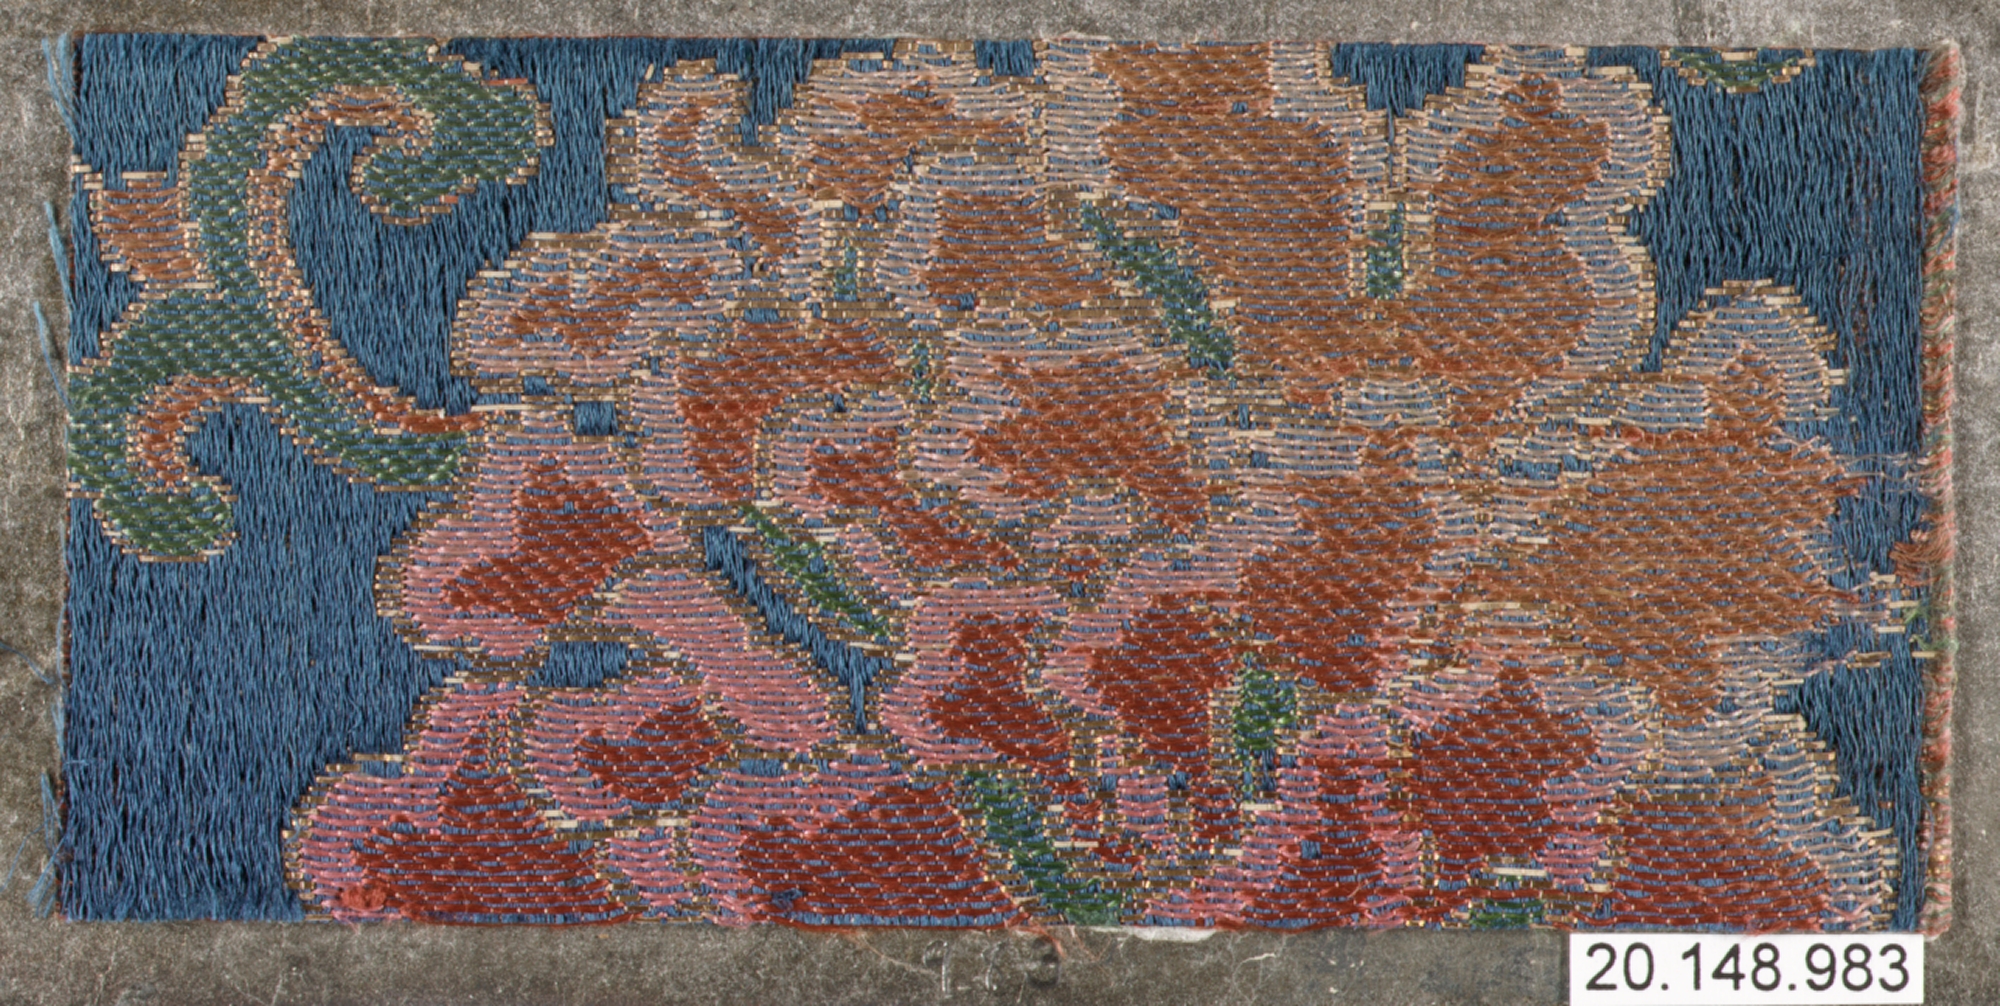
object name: piece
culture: chinese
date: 1701-1800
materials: silk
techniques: compound weave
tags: flowers